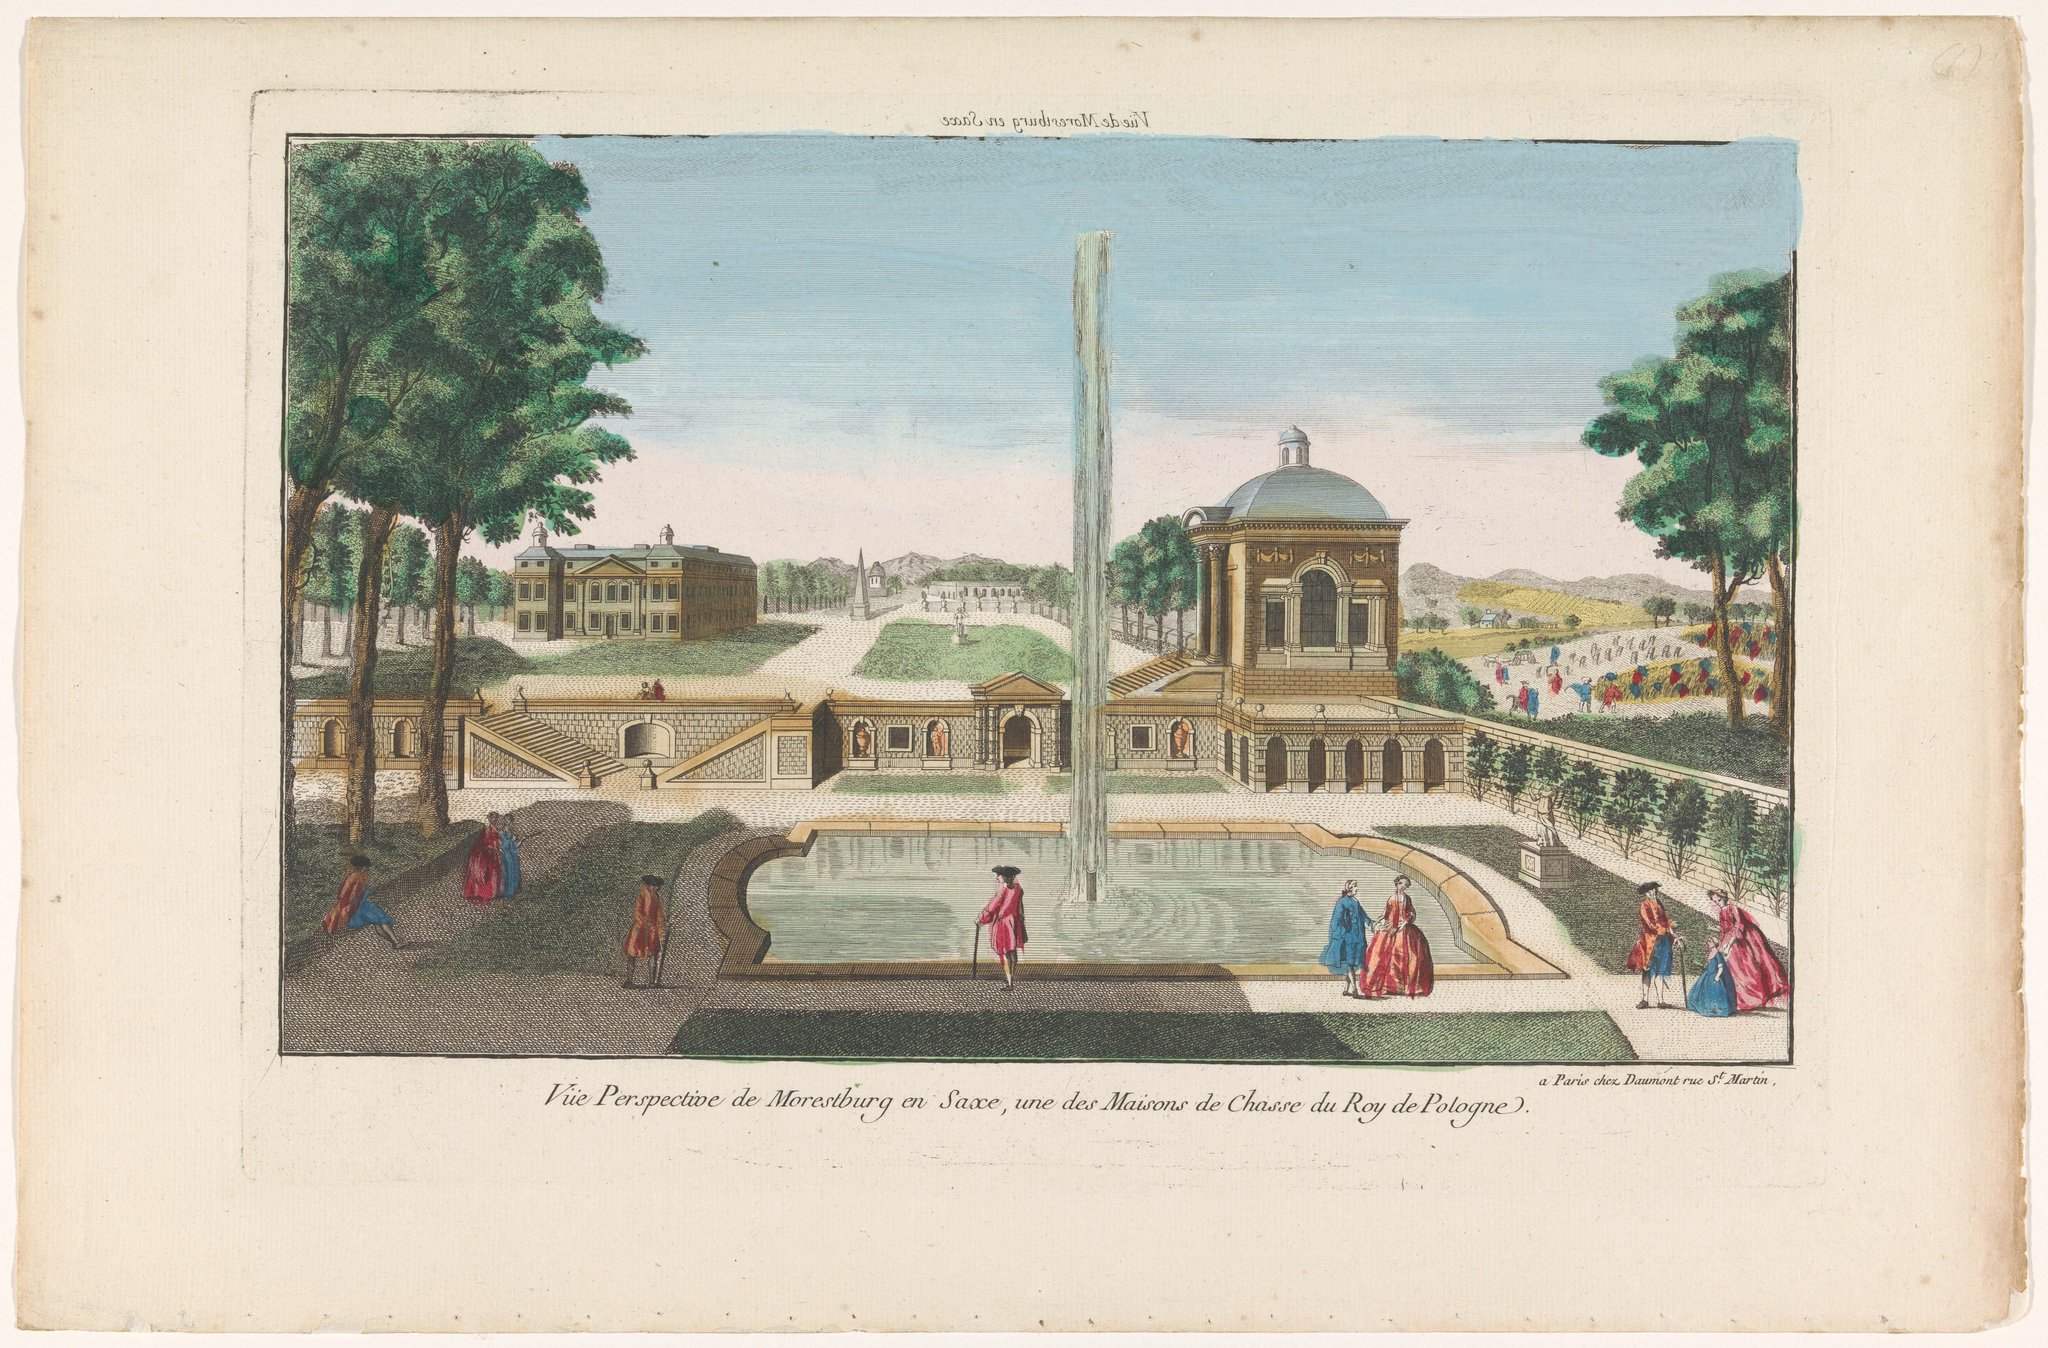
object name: opticaprent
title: Gezicht op het Schloss Moritzburg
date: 1745-1775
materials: paper, watercolor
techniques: brush, etching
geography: paris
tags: garden fountain, hunting-seat, hunting lodge, 'rendez-vous de chasse', 'jagdschloss'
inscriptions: collector's mark: Lugt 2166, watermark